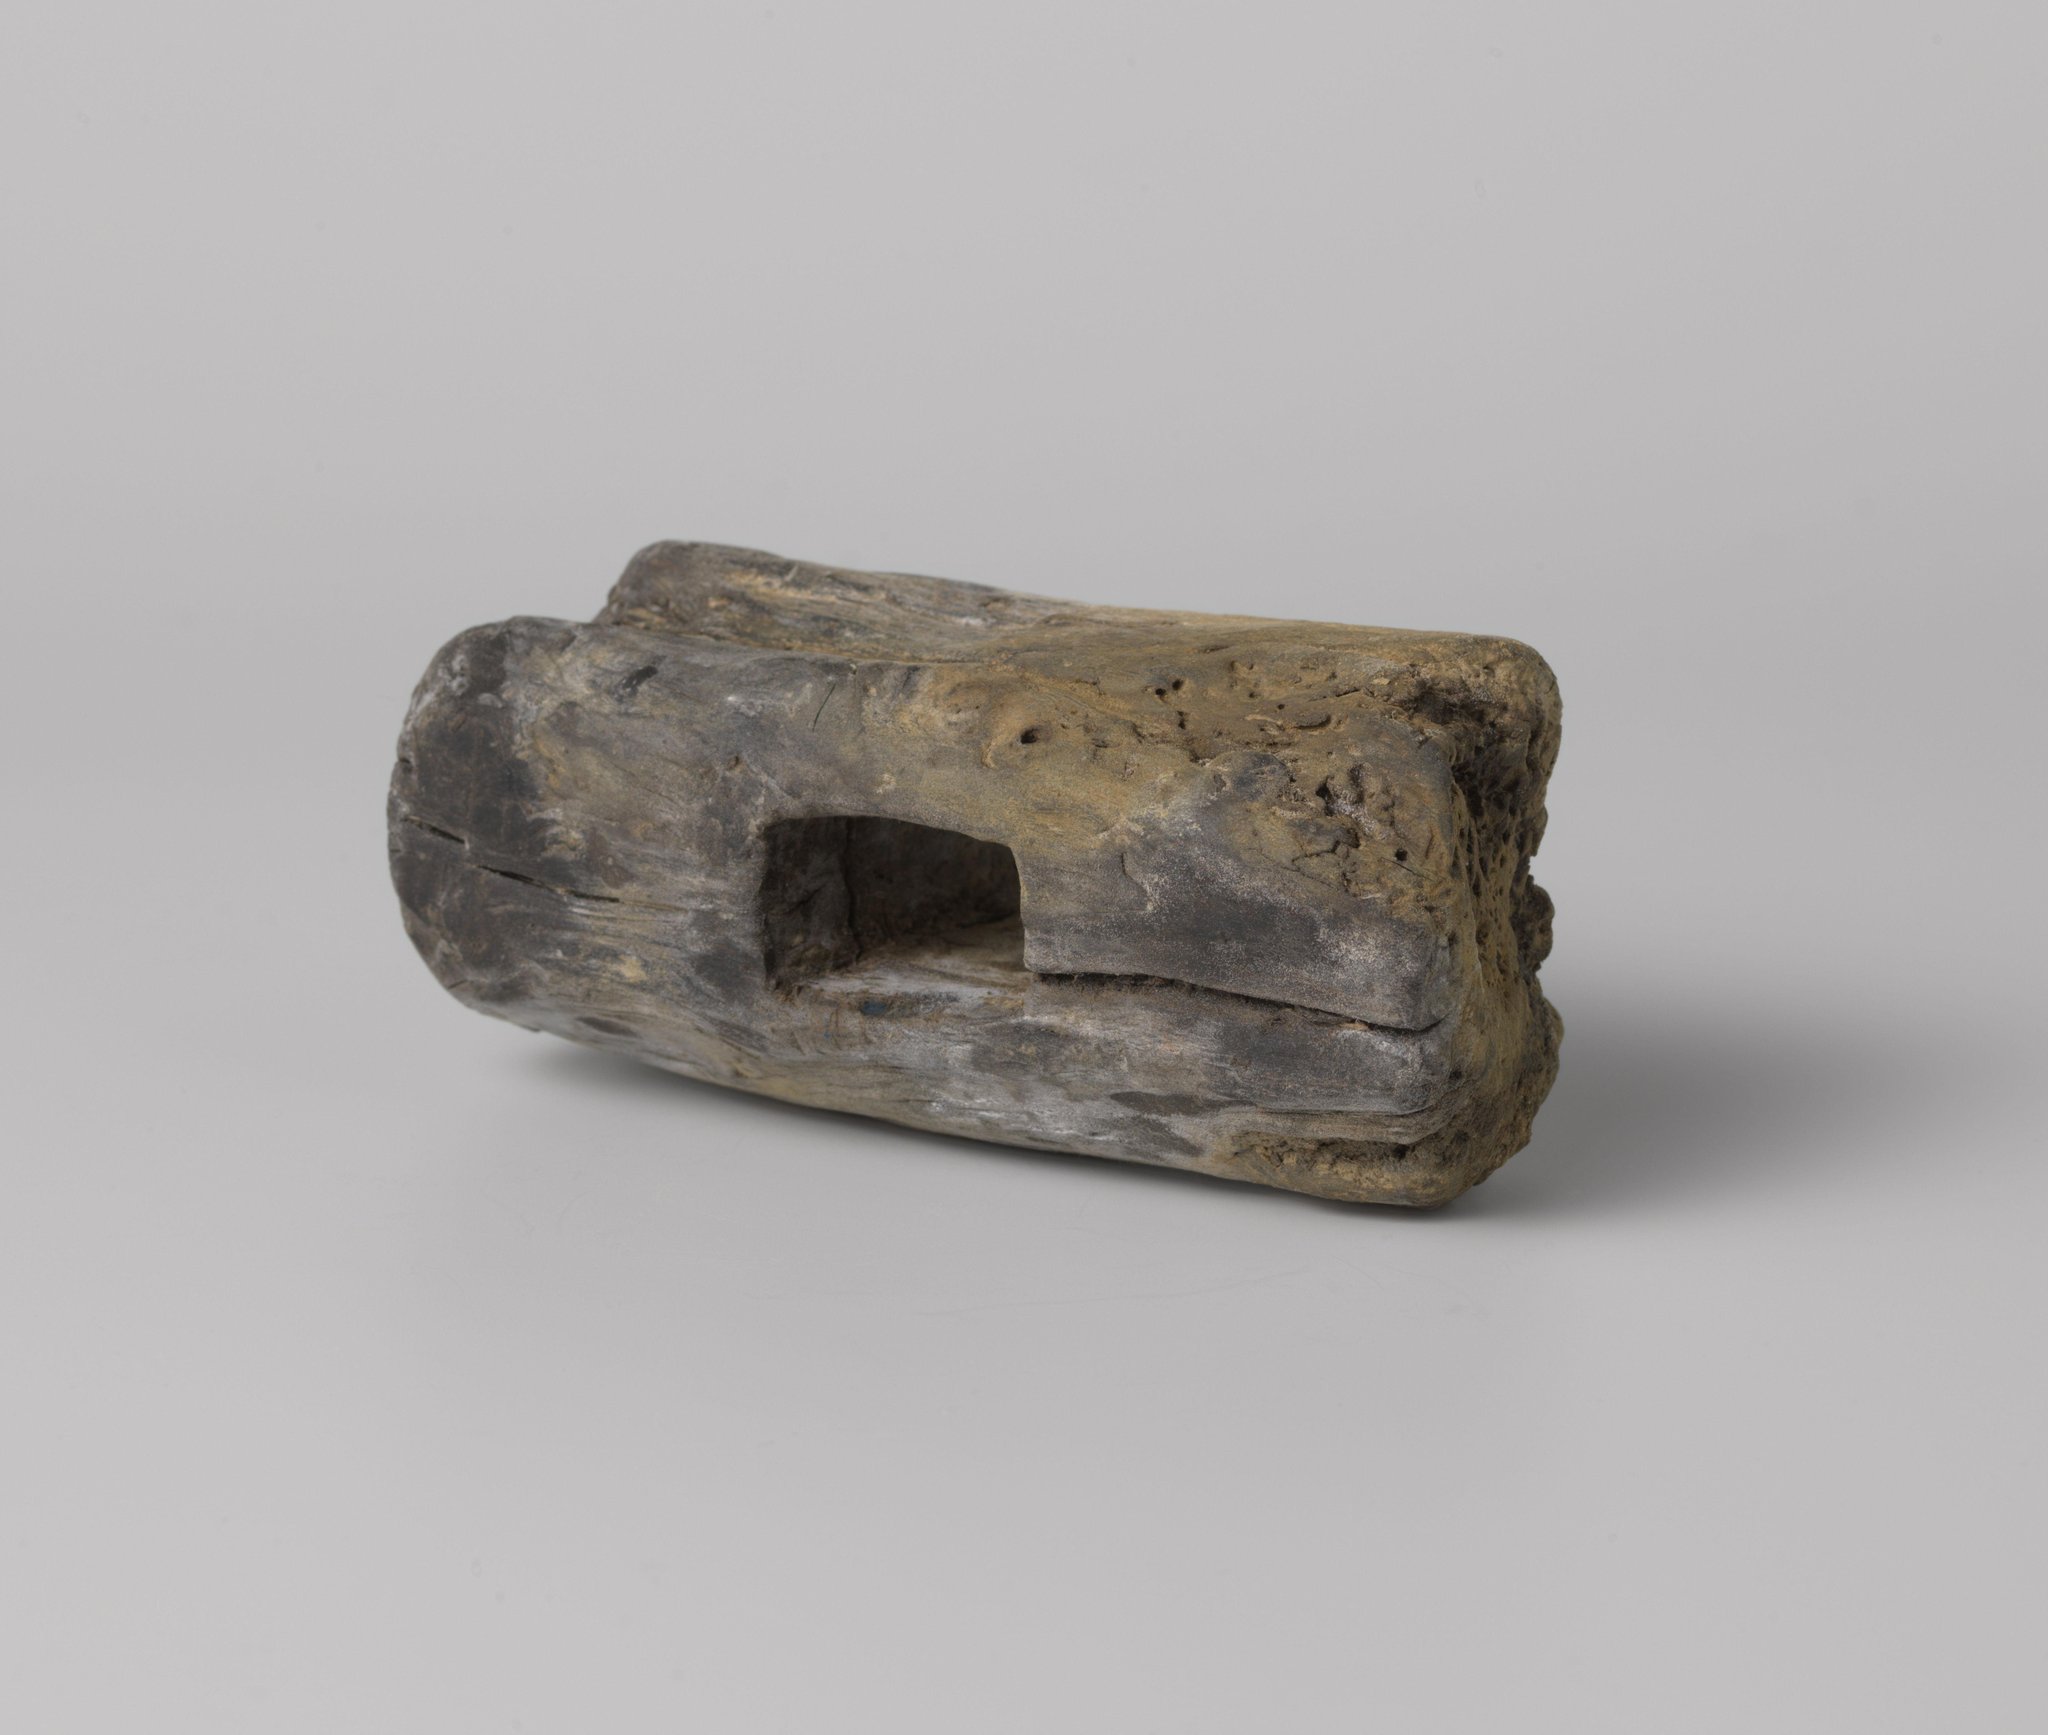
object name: hammer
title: Kop van een hamer uit V.O.C.-schip de 'Witte Leeuw'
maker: Anonymous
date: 1613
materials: wood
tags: verenigde oostindische compagnie, sint-helena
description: Kop van een hamer uit V.O.C.-schip de 'Witte Leeuw'.